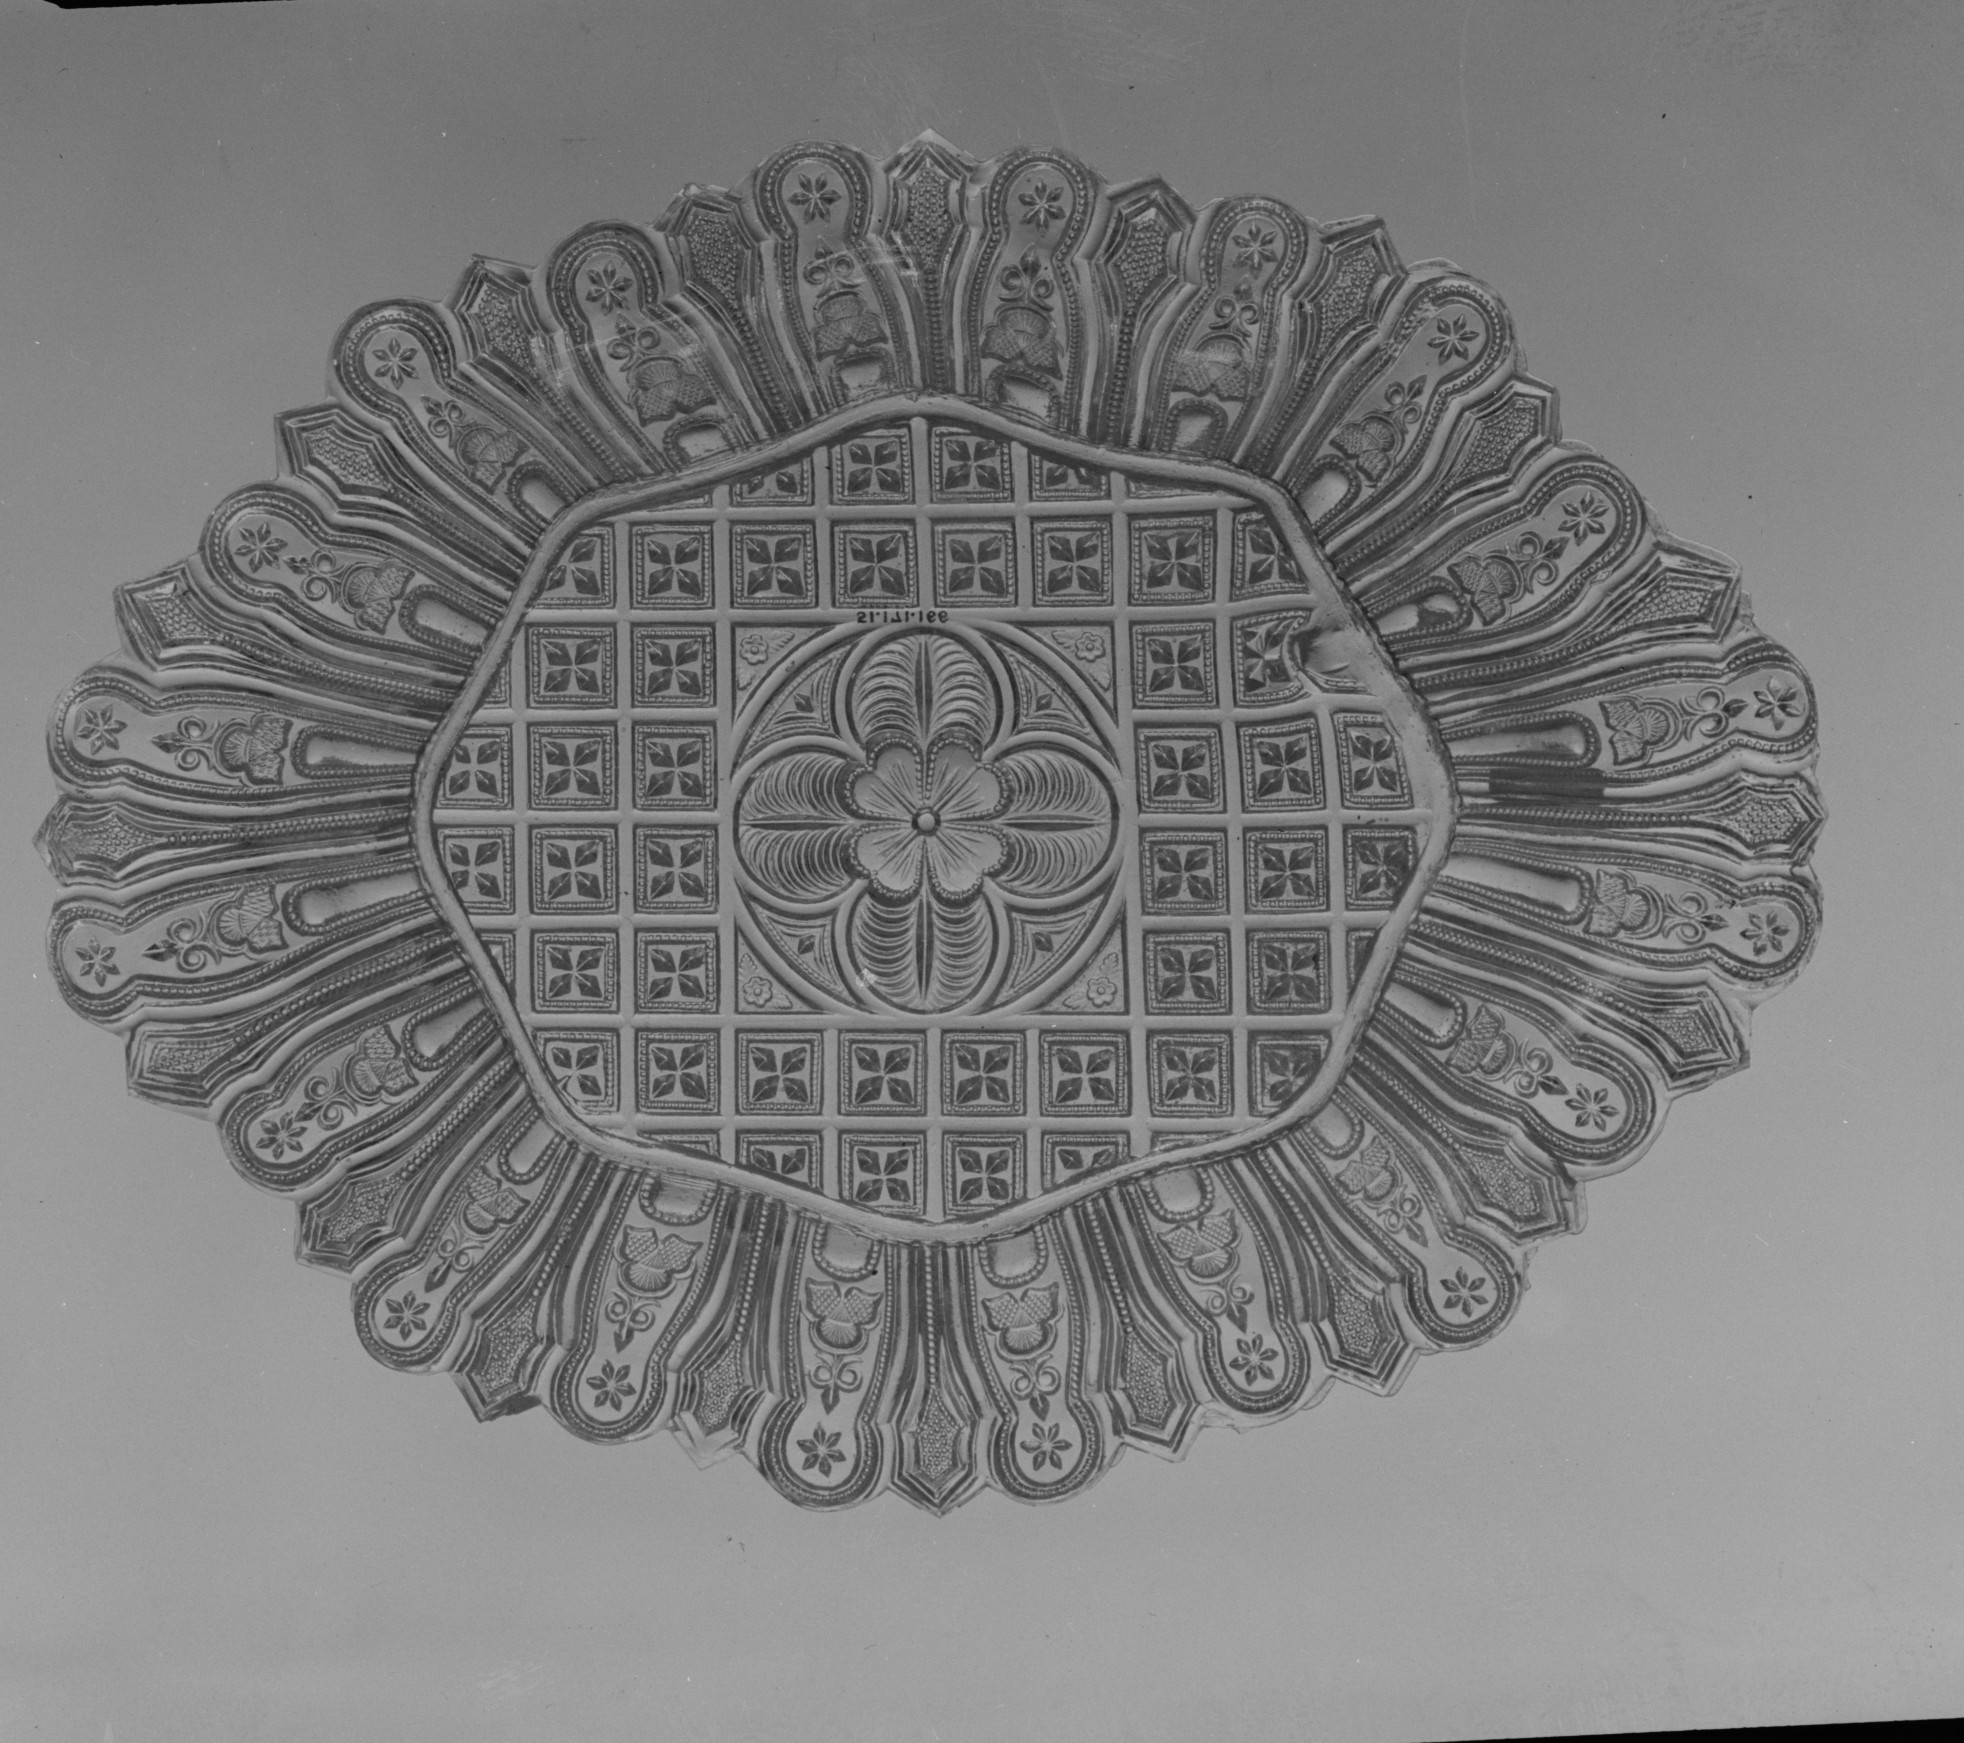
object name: dish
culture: american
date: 1830-1835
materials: glass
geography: united states